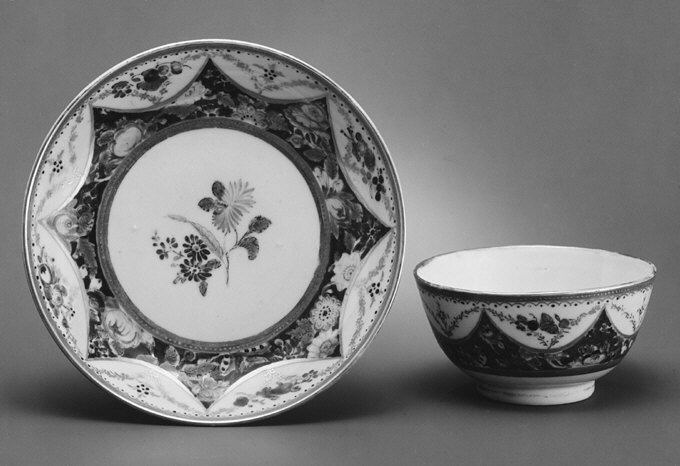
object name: teabowl and saucer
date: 1820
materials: hard paste porcelain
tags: flowers